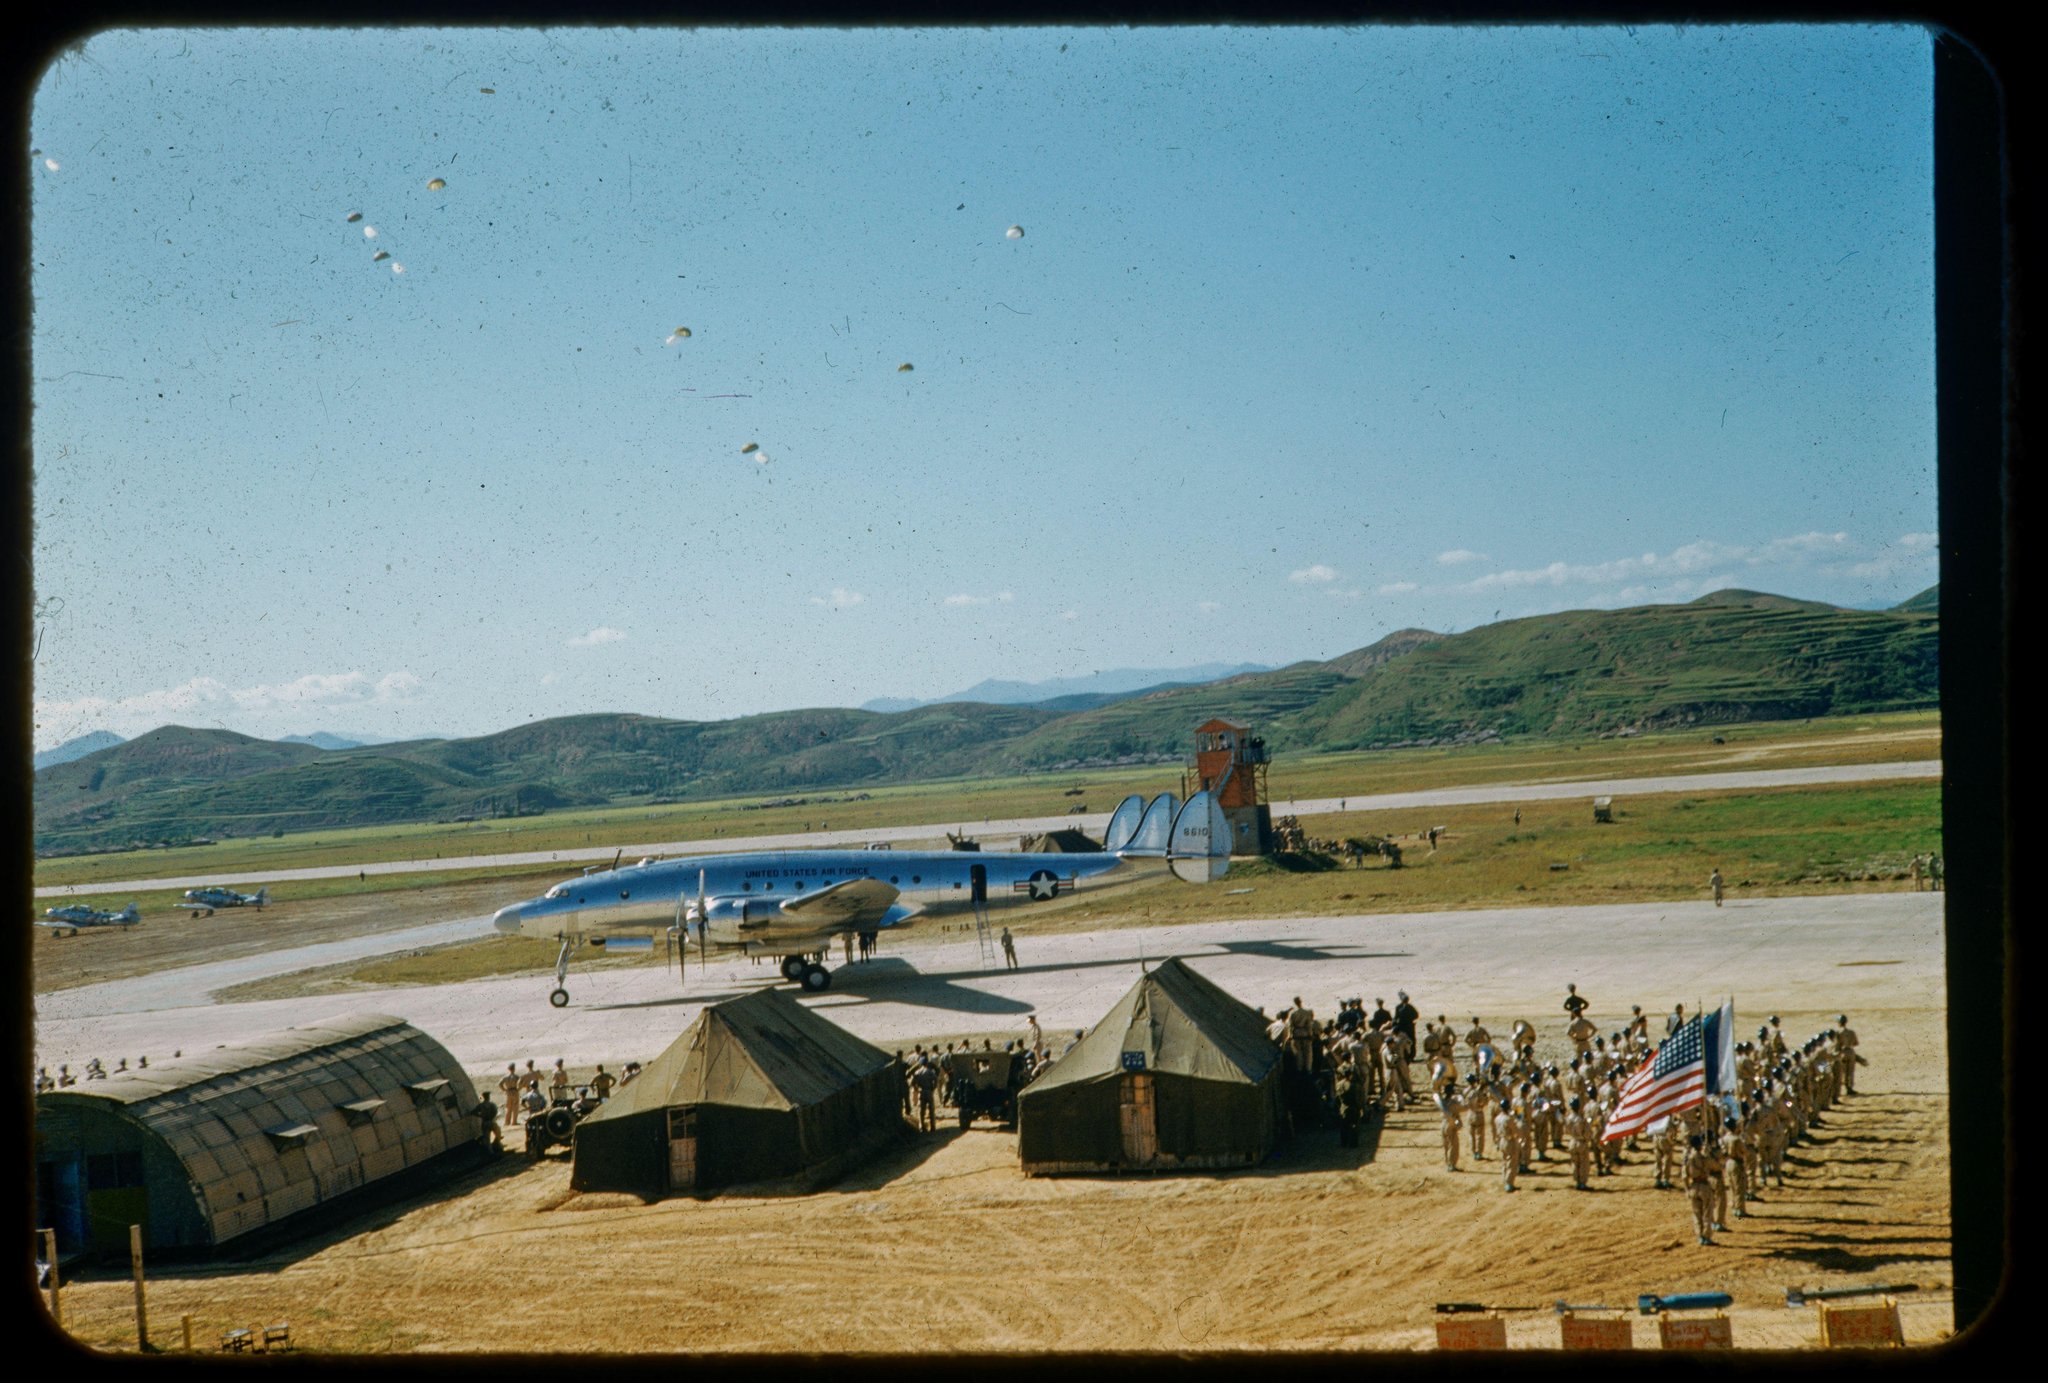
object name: color slide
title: Oorlog in Korea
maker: david ketel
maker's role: diplomaat, sinoloog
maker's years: 1913-2008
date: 1909-1952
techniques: slide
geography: korea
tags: united nations